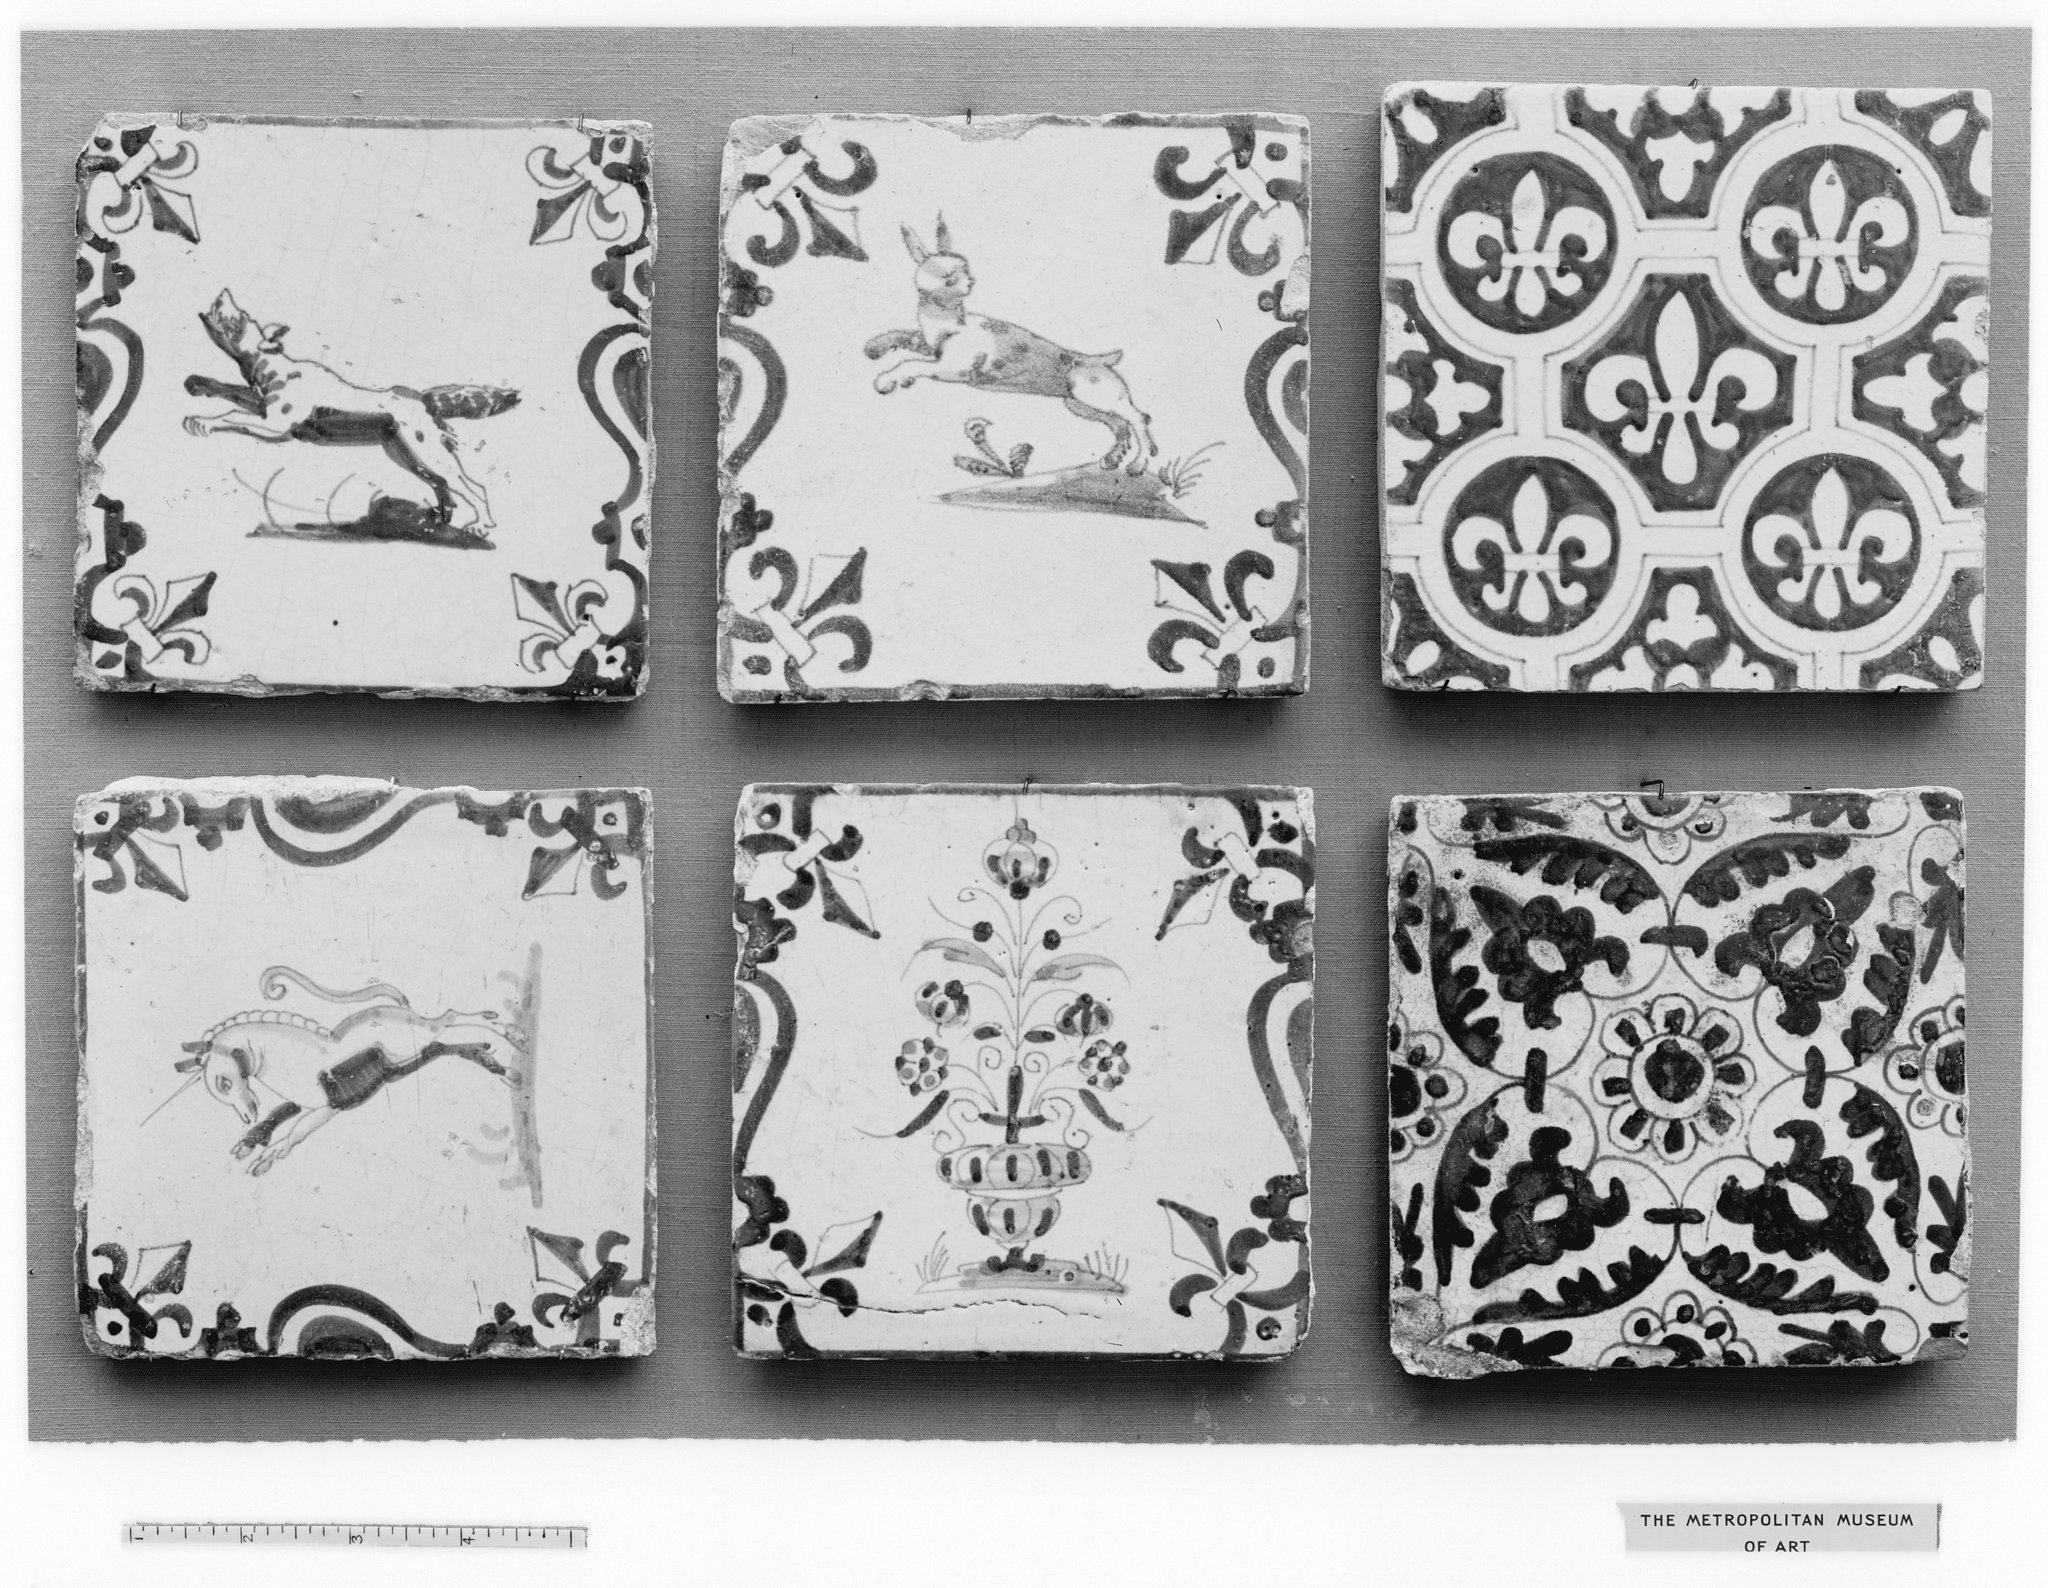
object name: tile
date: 1620-1640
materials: earthenware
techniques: glazing